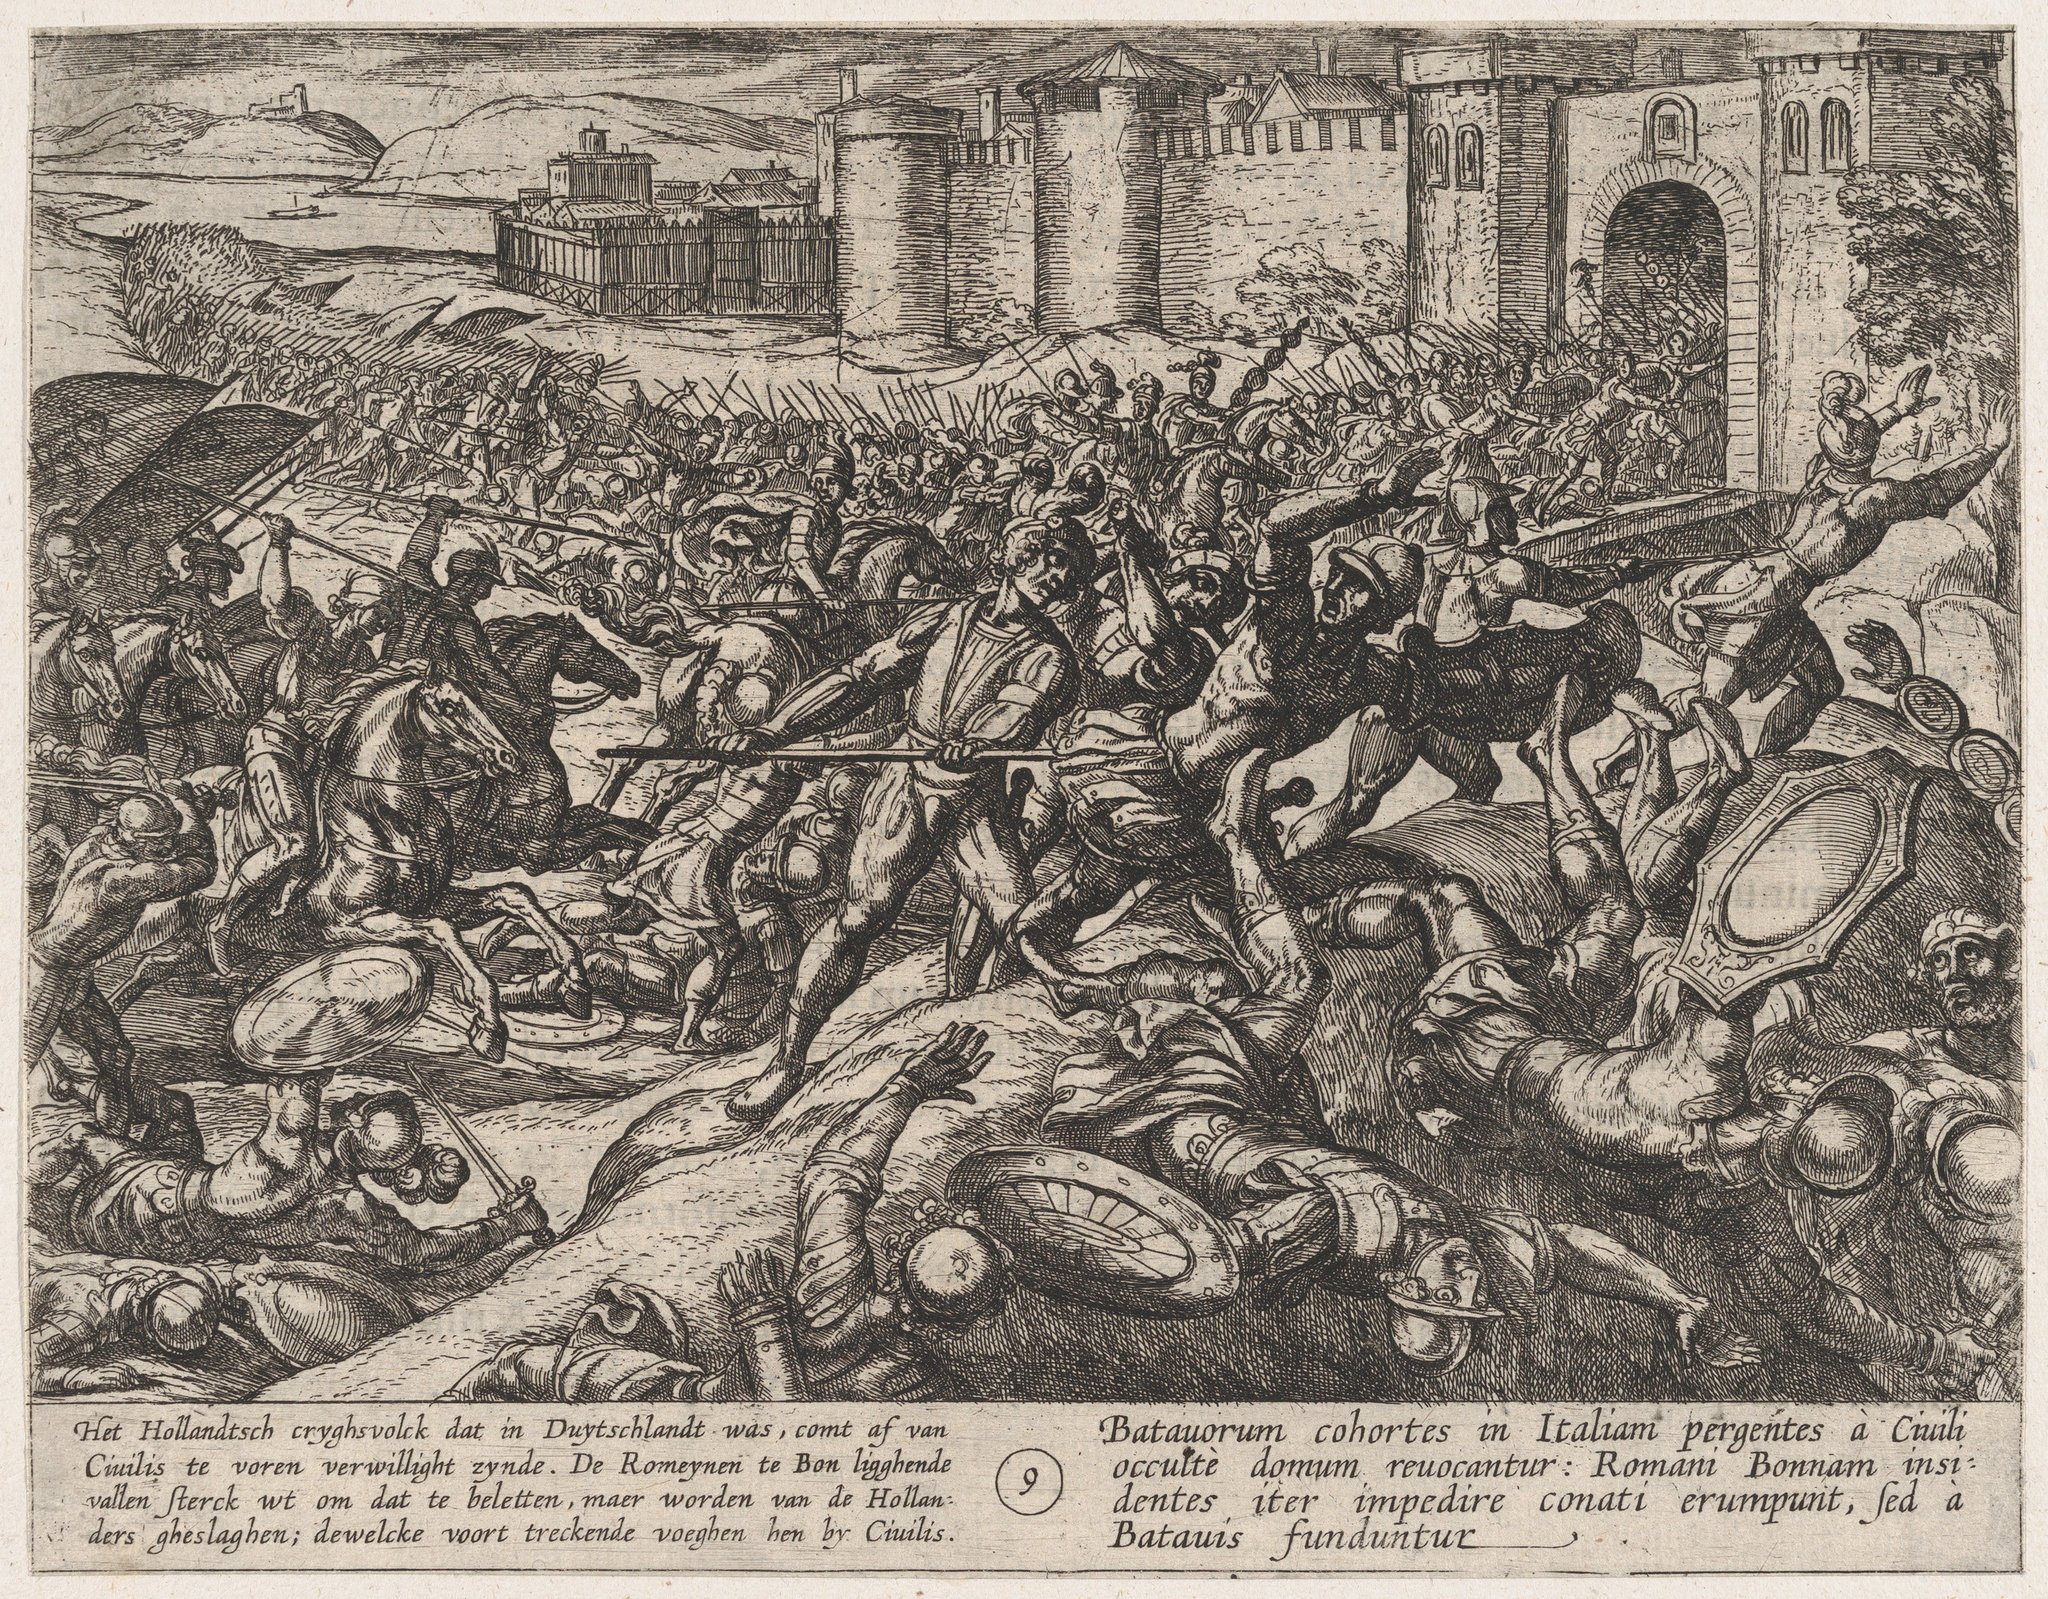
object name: print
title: Plate 9: The Romans Defeated by the Dutch Troops at Bonna, from The War of the Romans Against the Batavians (Romanorvm et Batavorvm societas)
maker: antonio tempesta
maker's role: artist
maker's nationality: italian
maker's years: 1555-1630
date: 1611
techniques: etching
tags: wars,soldiers,shields,weapons,horses